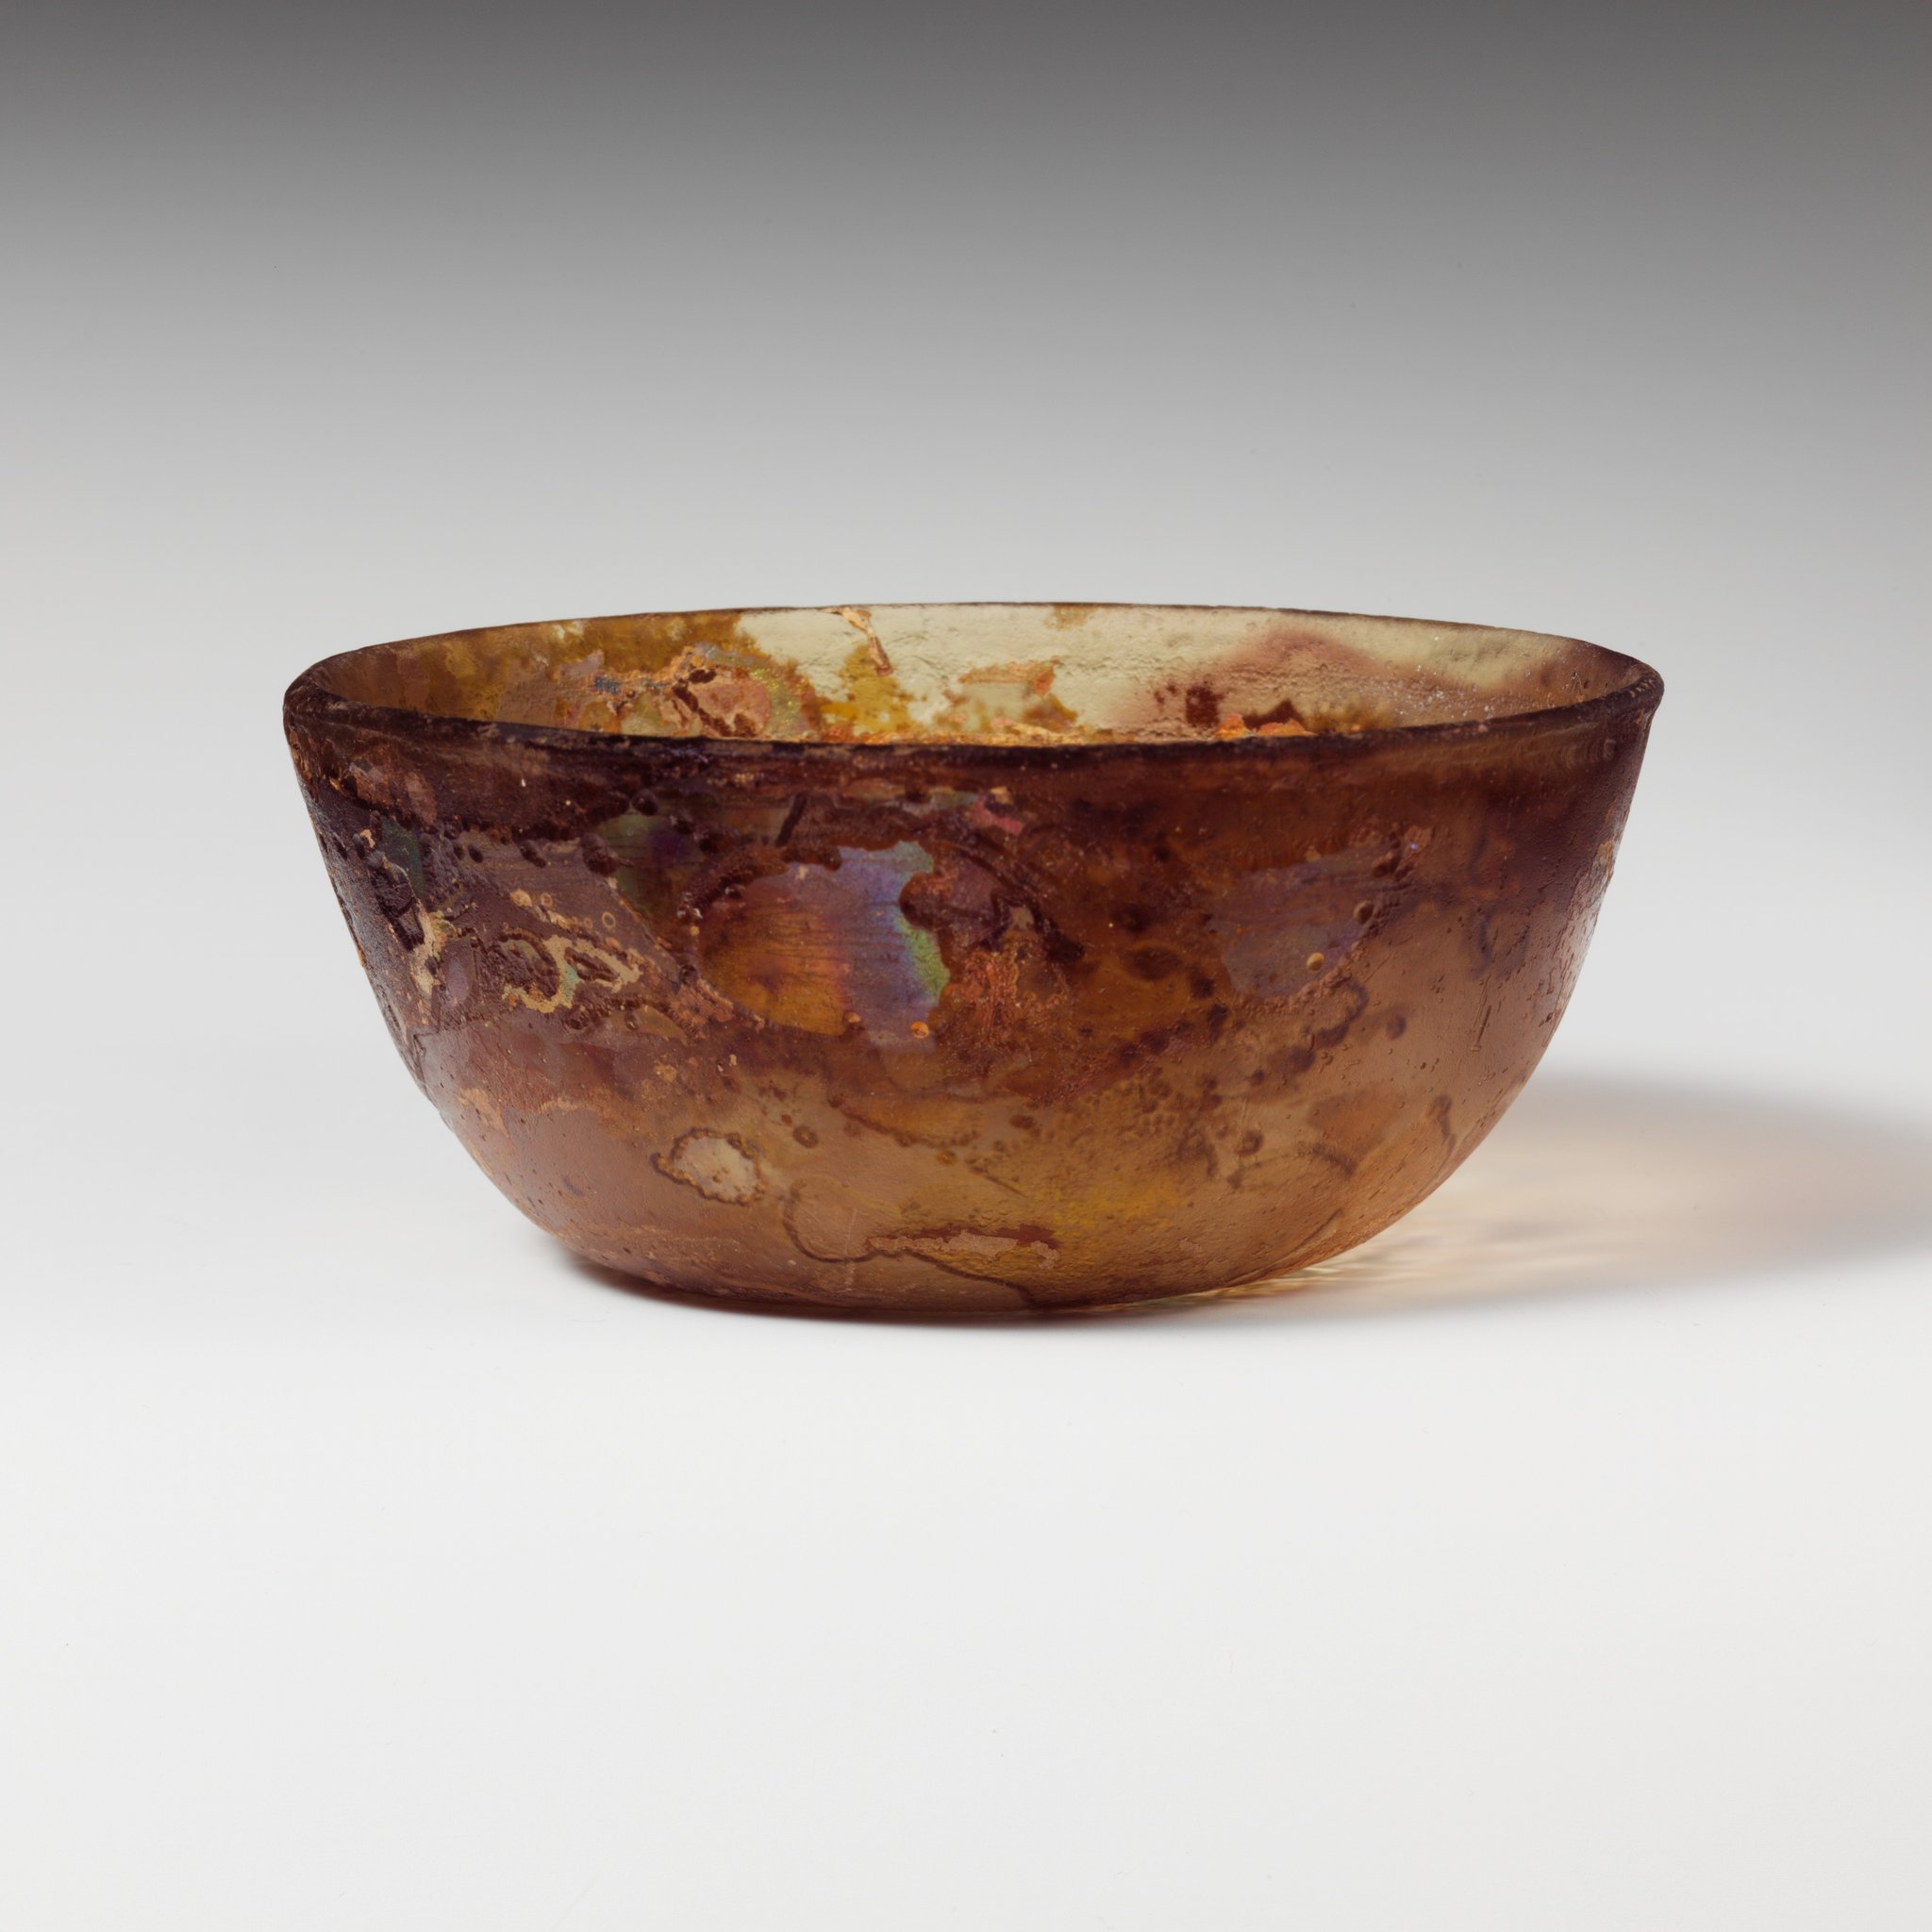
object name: bowl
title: Glass bowl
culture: roman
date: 34 BCE-33 CE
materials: glass